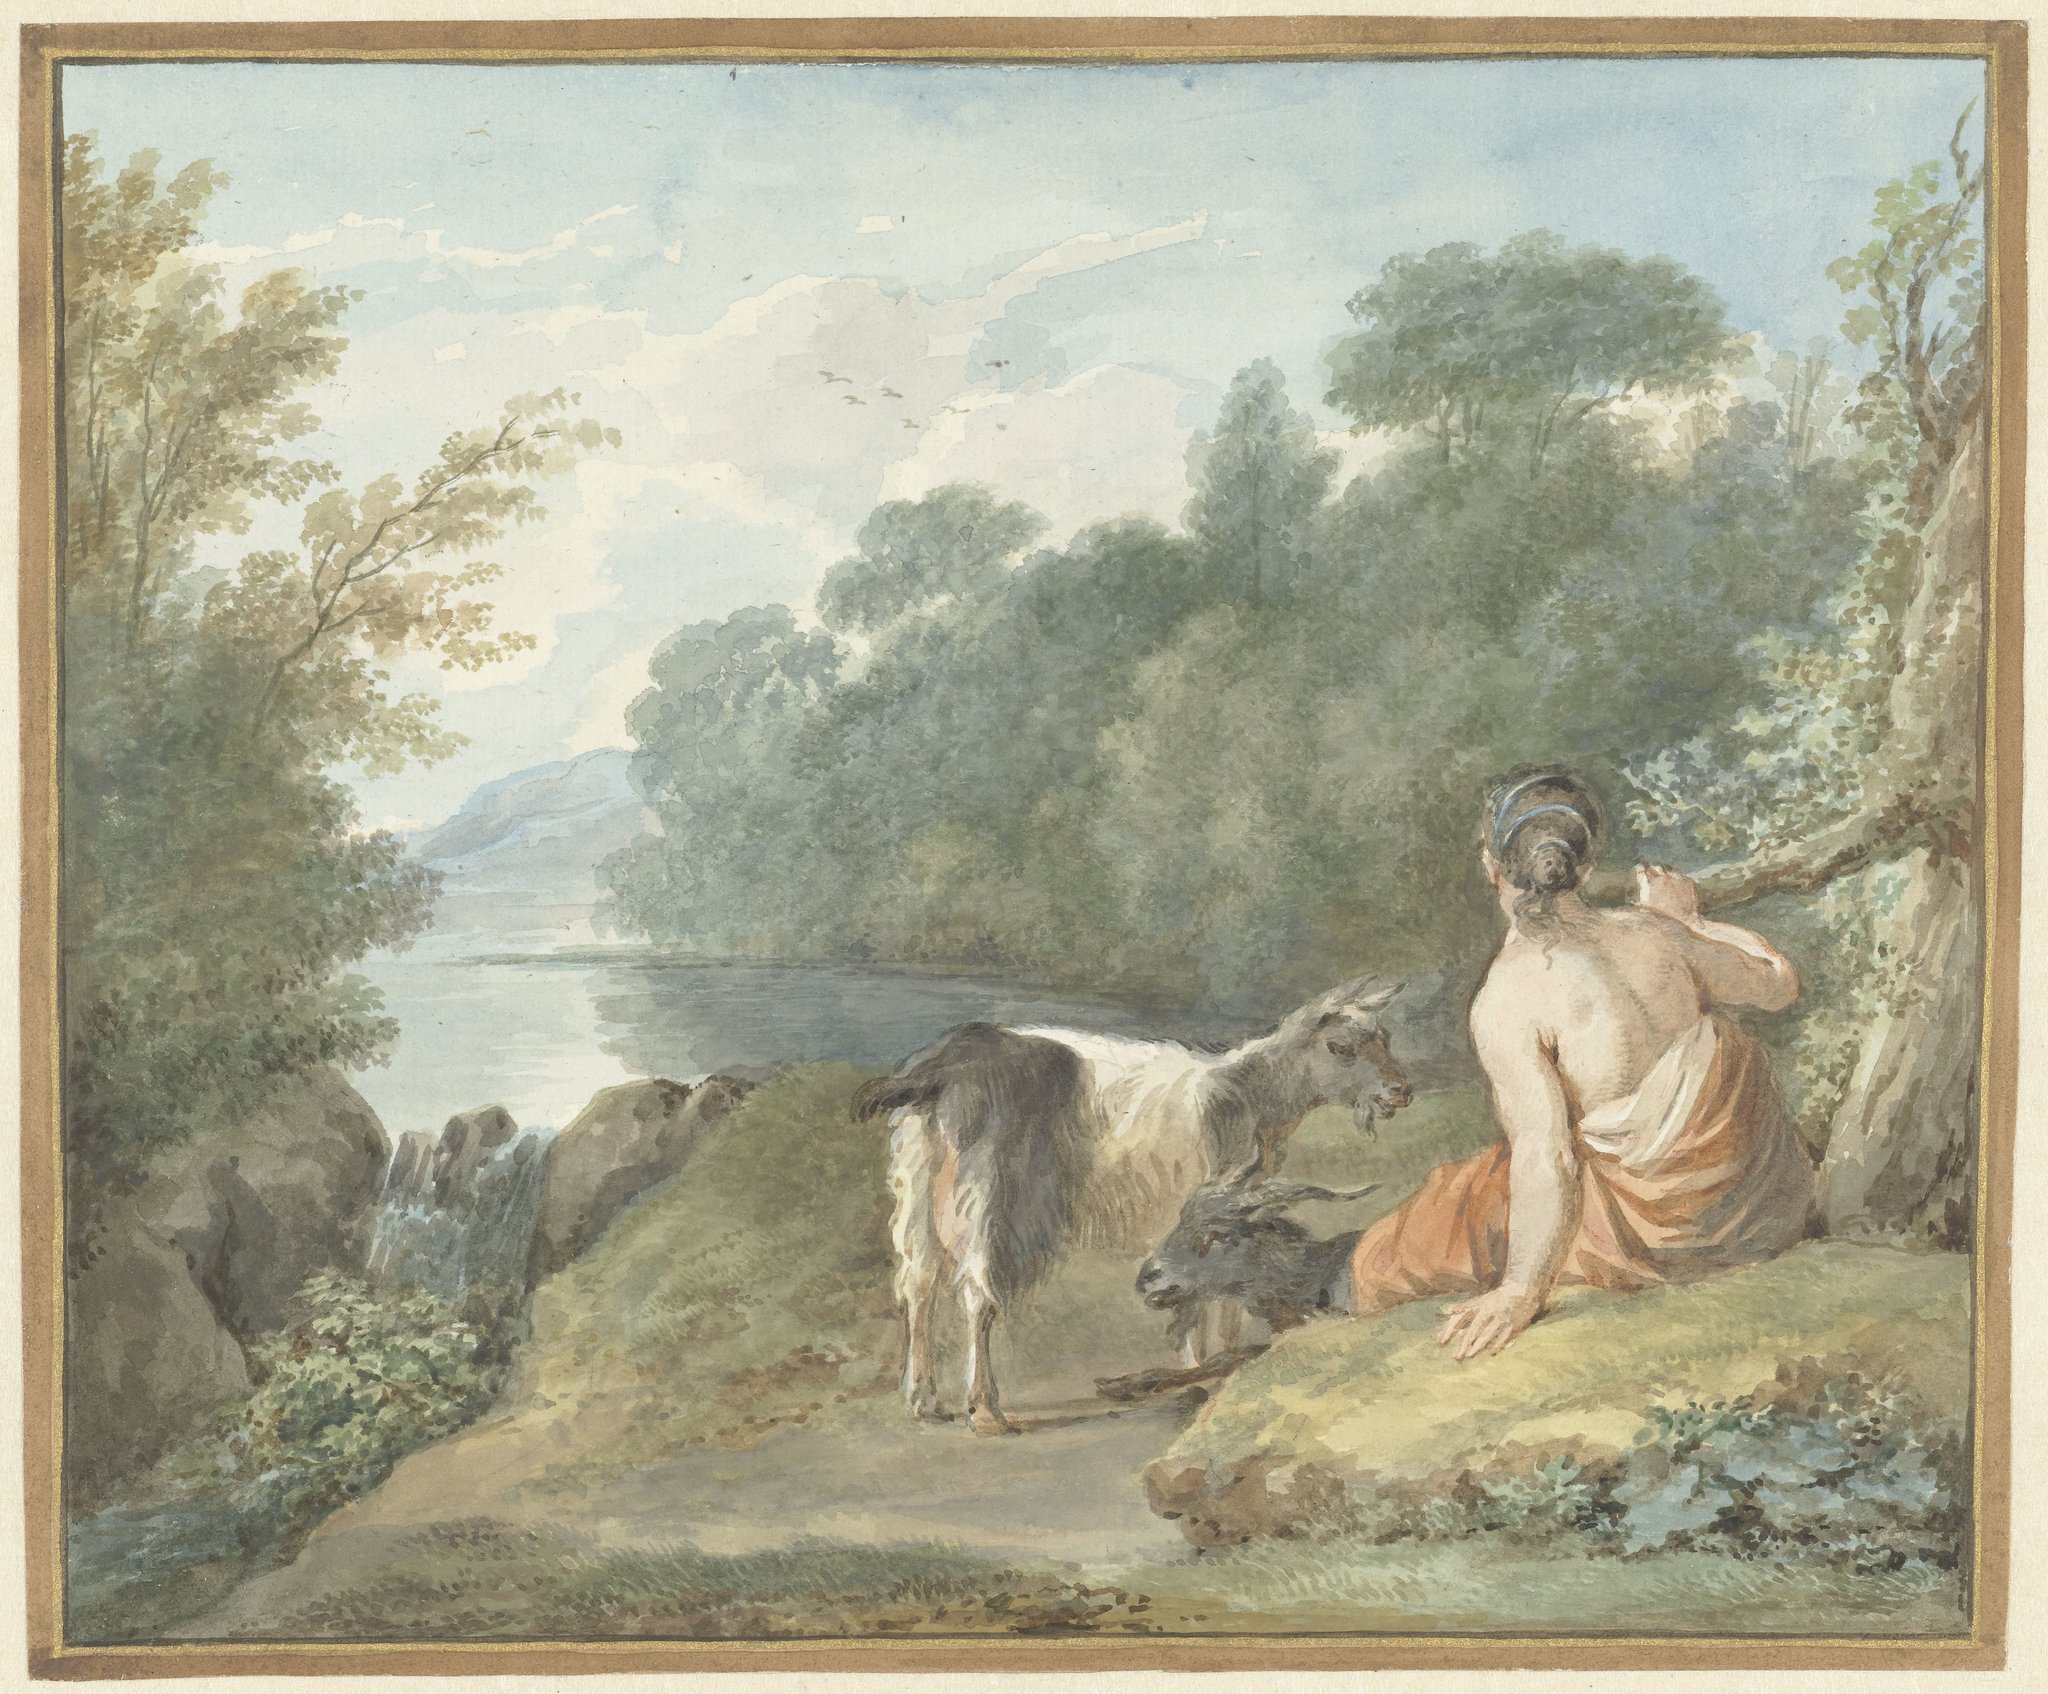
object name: watercolor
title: Herderin met geiten in een landschap met een meer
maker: aert schouman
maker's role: draughtsman, painter, print maker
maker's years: 1710-1792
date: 1781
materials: paint, paper, watercolor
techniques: brush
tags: landscapes, herding, herdsman, herdswoman, shepherd, shepherdess, cowherd, etc., goat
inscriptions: inscription: ‘A. Schouman fec. na een stukje van S. v.dr does. 1781 welk stukje onder zijn berustende is’